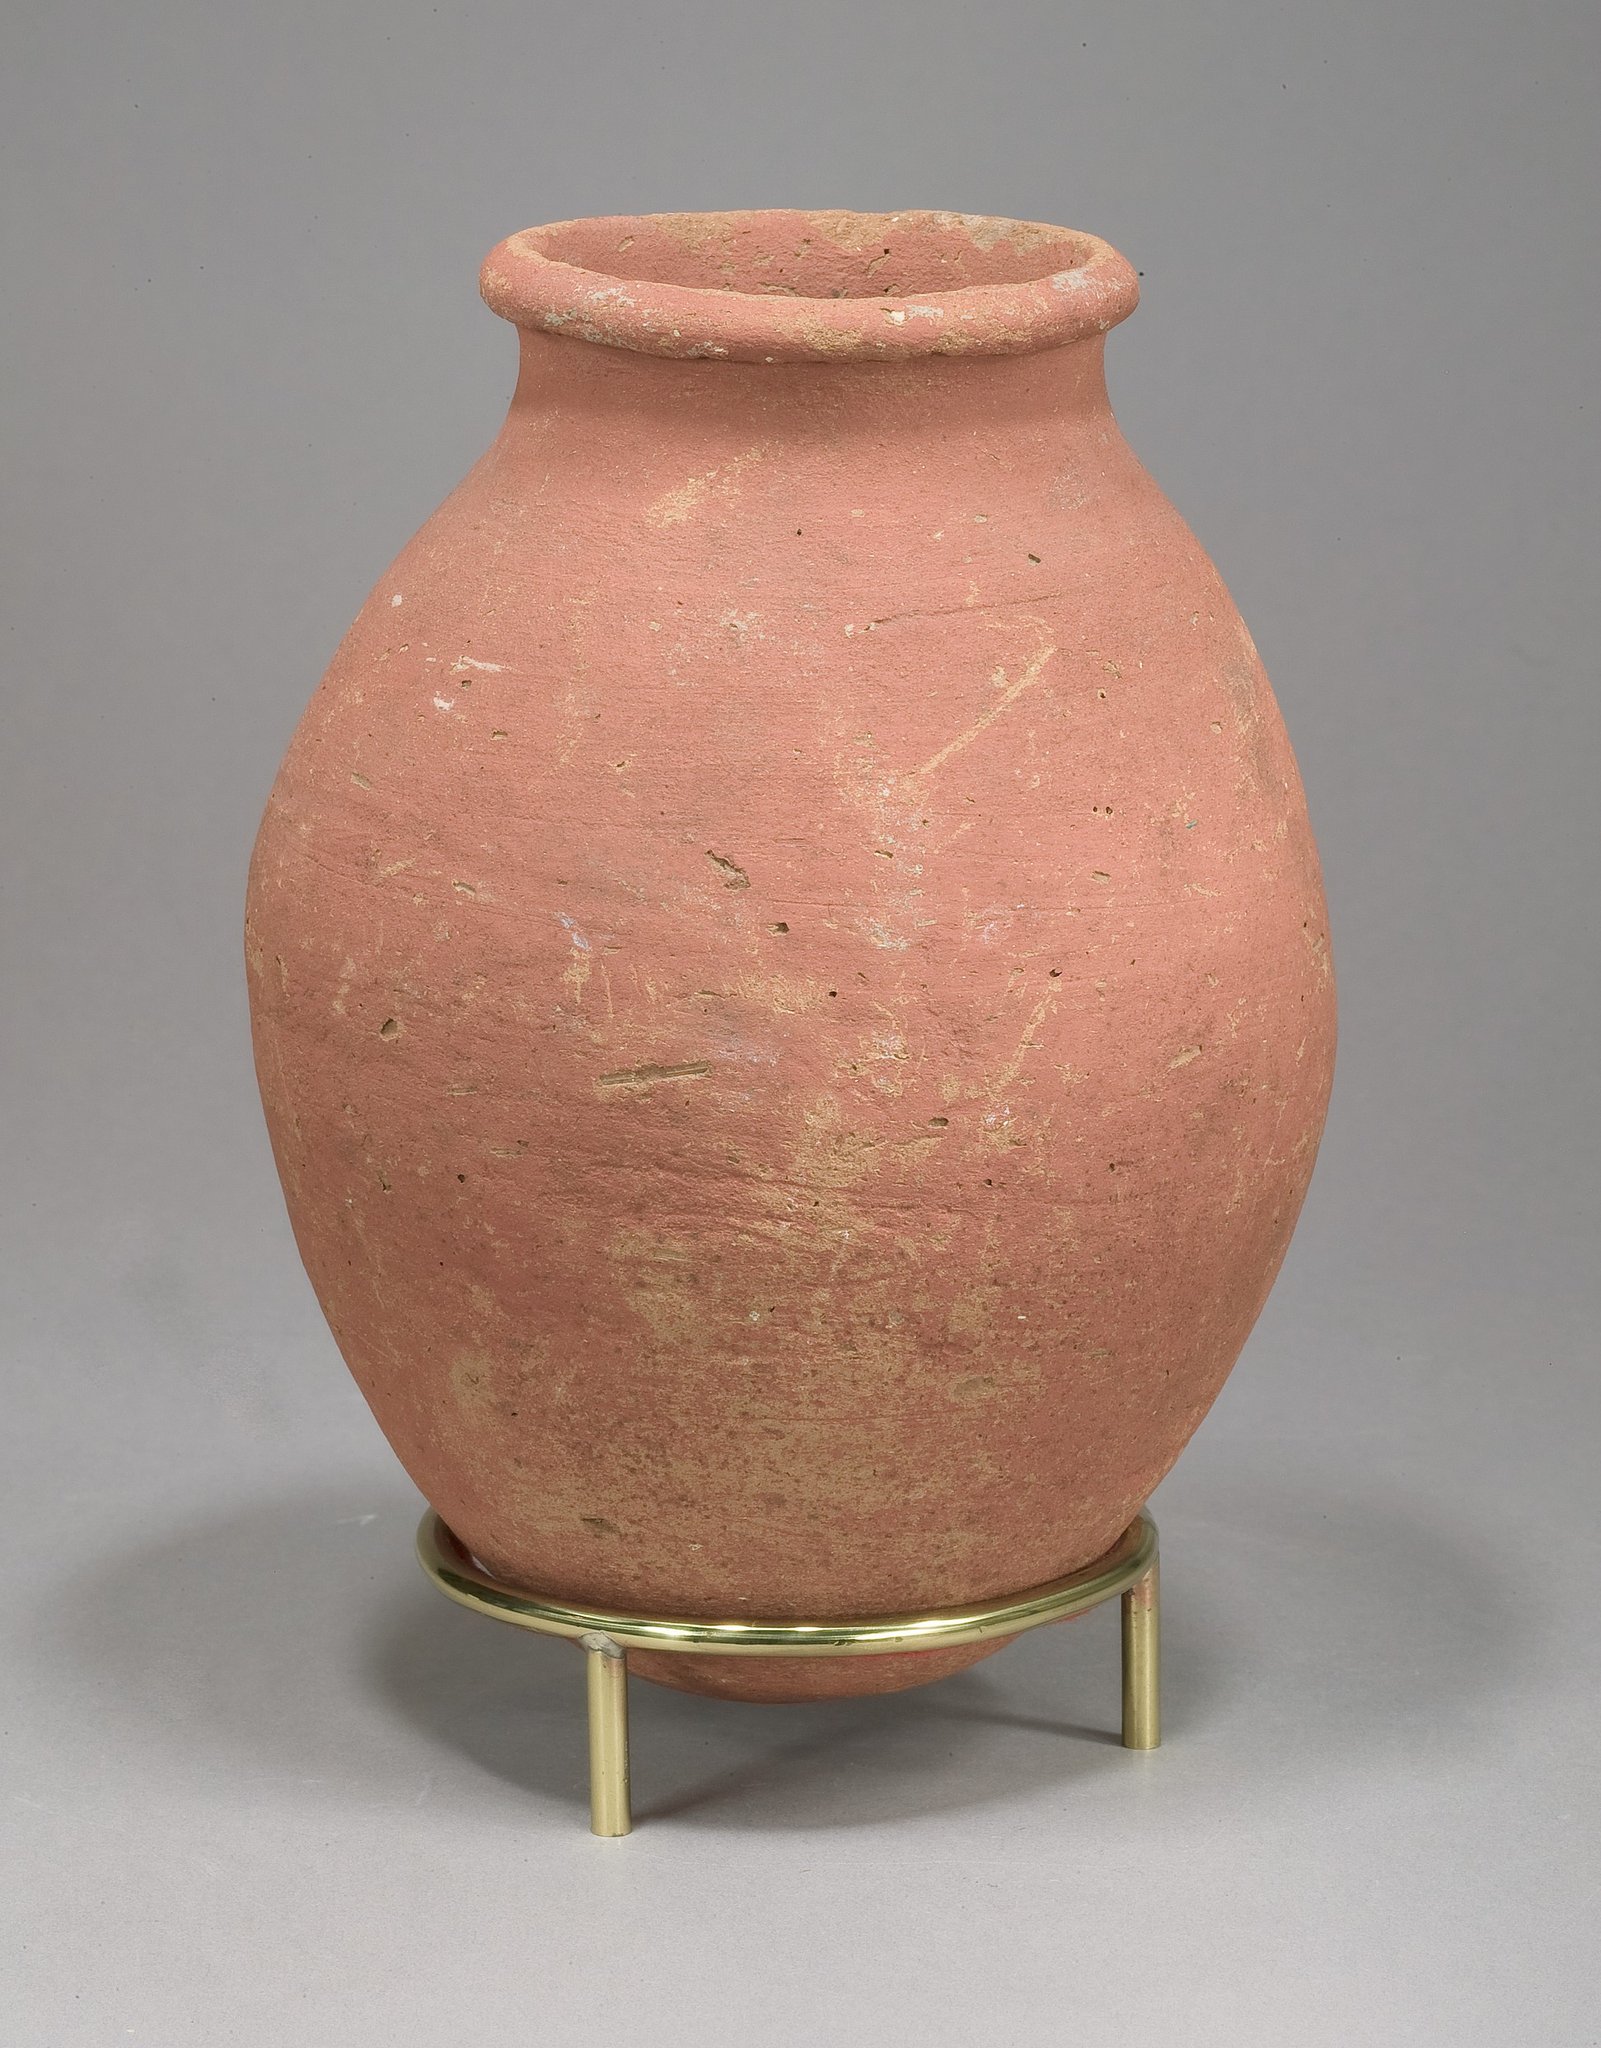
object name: jar, painted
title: Jar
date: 1919-1878 BCE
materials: mineral, pottery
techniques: wash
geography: egypt